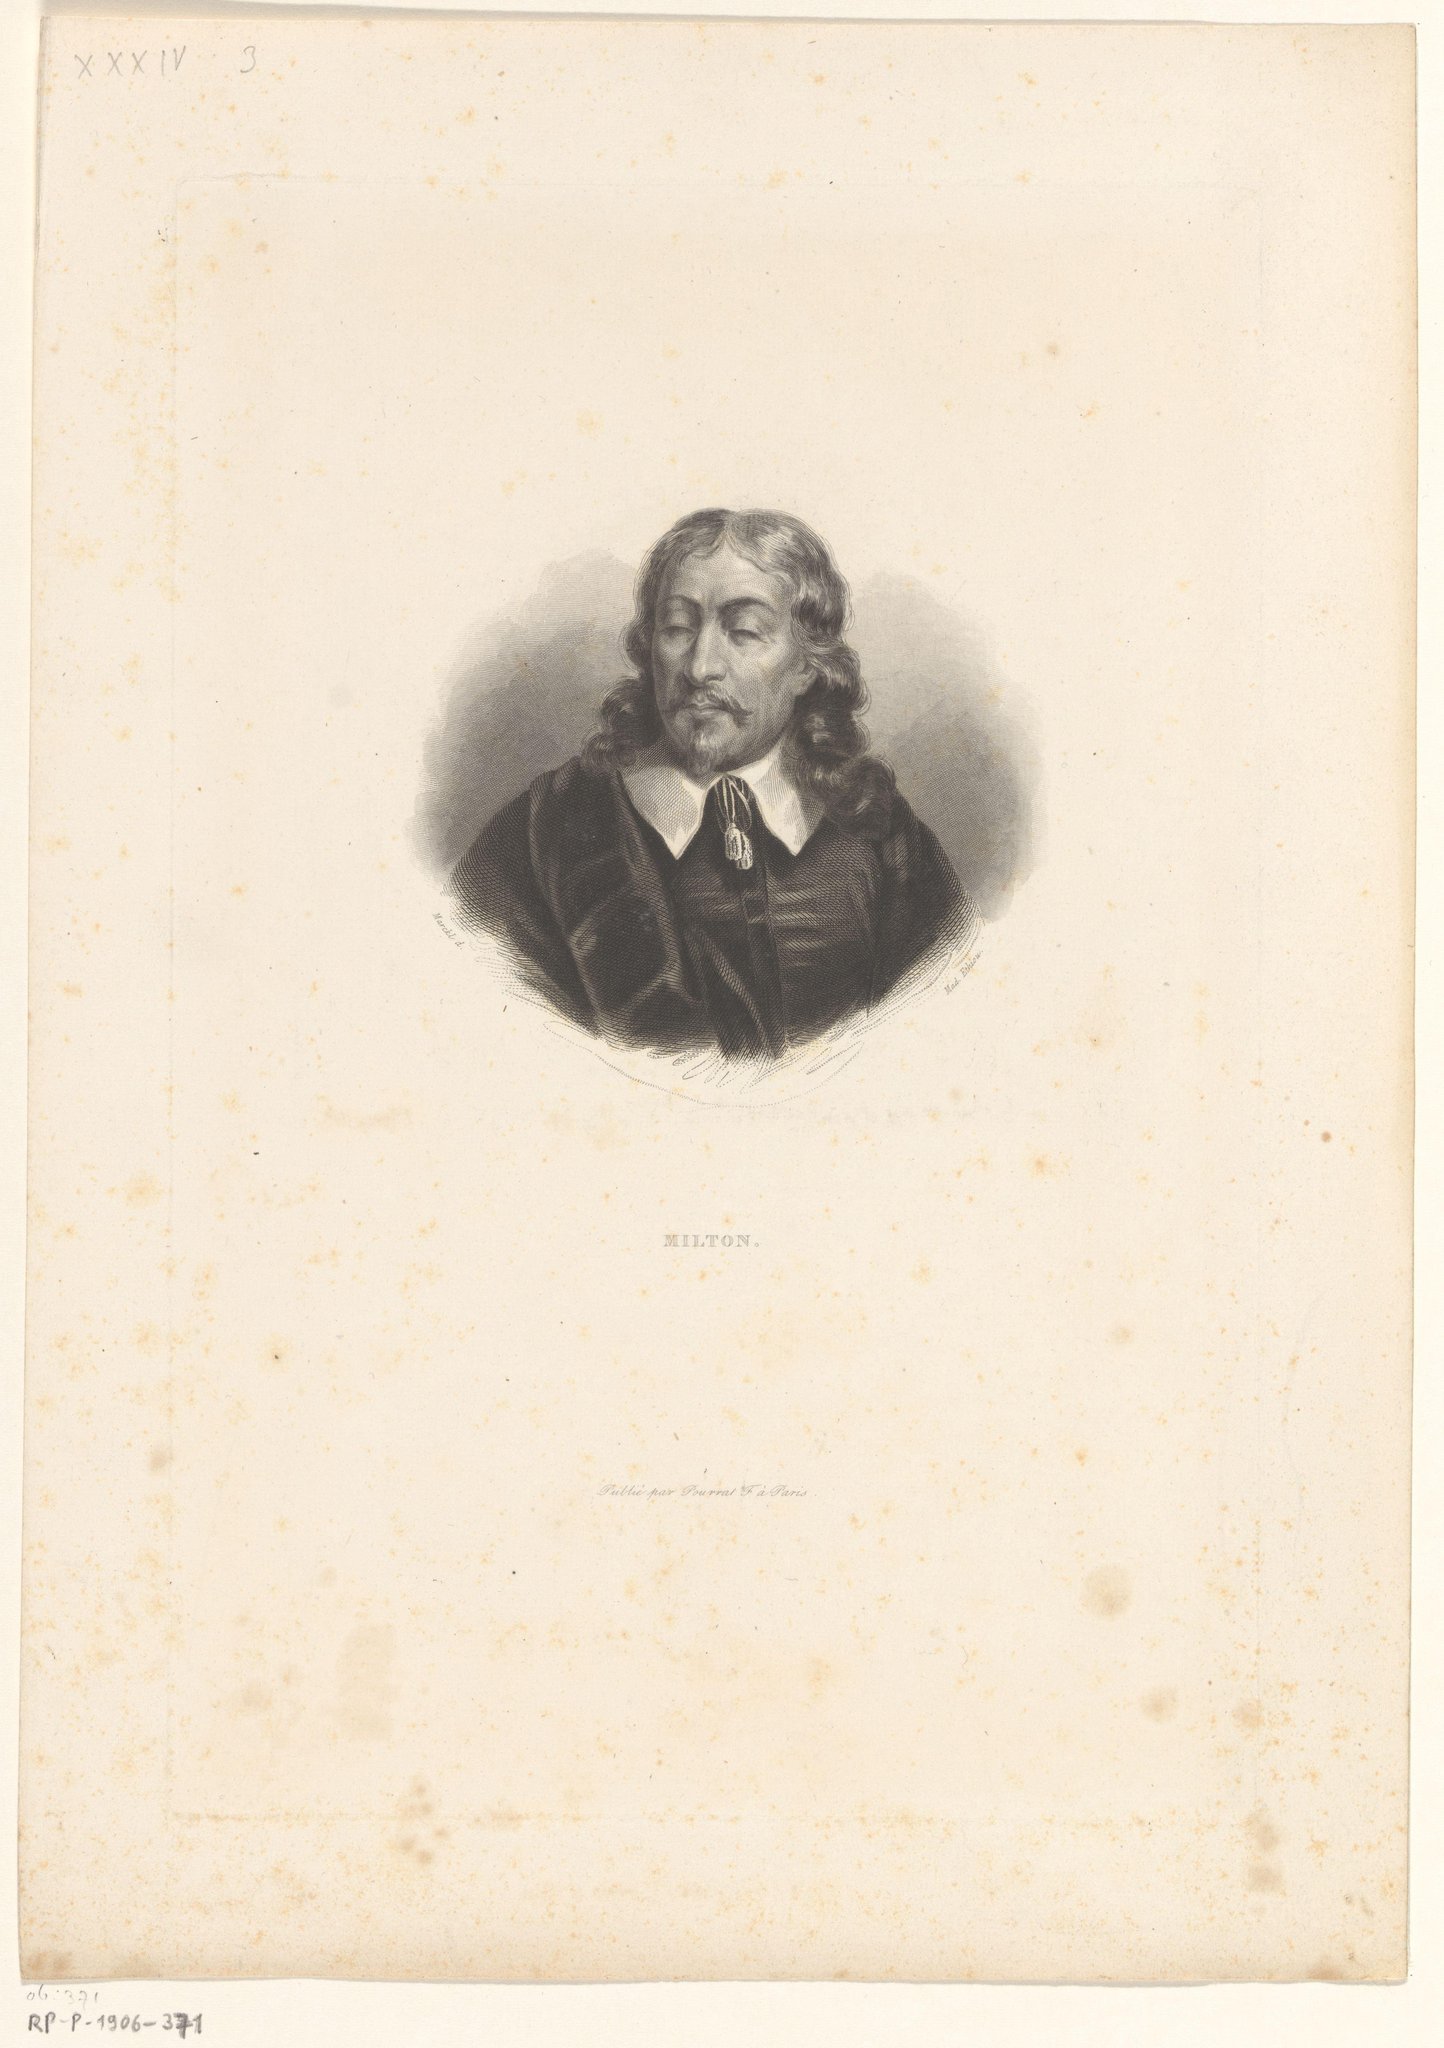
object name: print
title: Portret van John Milton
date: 1815-1825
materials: paper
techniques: engraving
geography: france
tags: london, john milton, blind, blindness, portrait of a writer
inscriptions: collector's mark: Lugt 2228